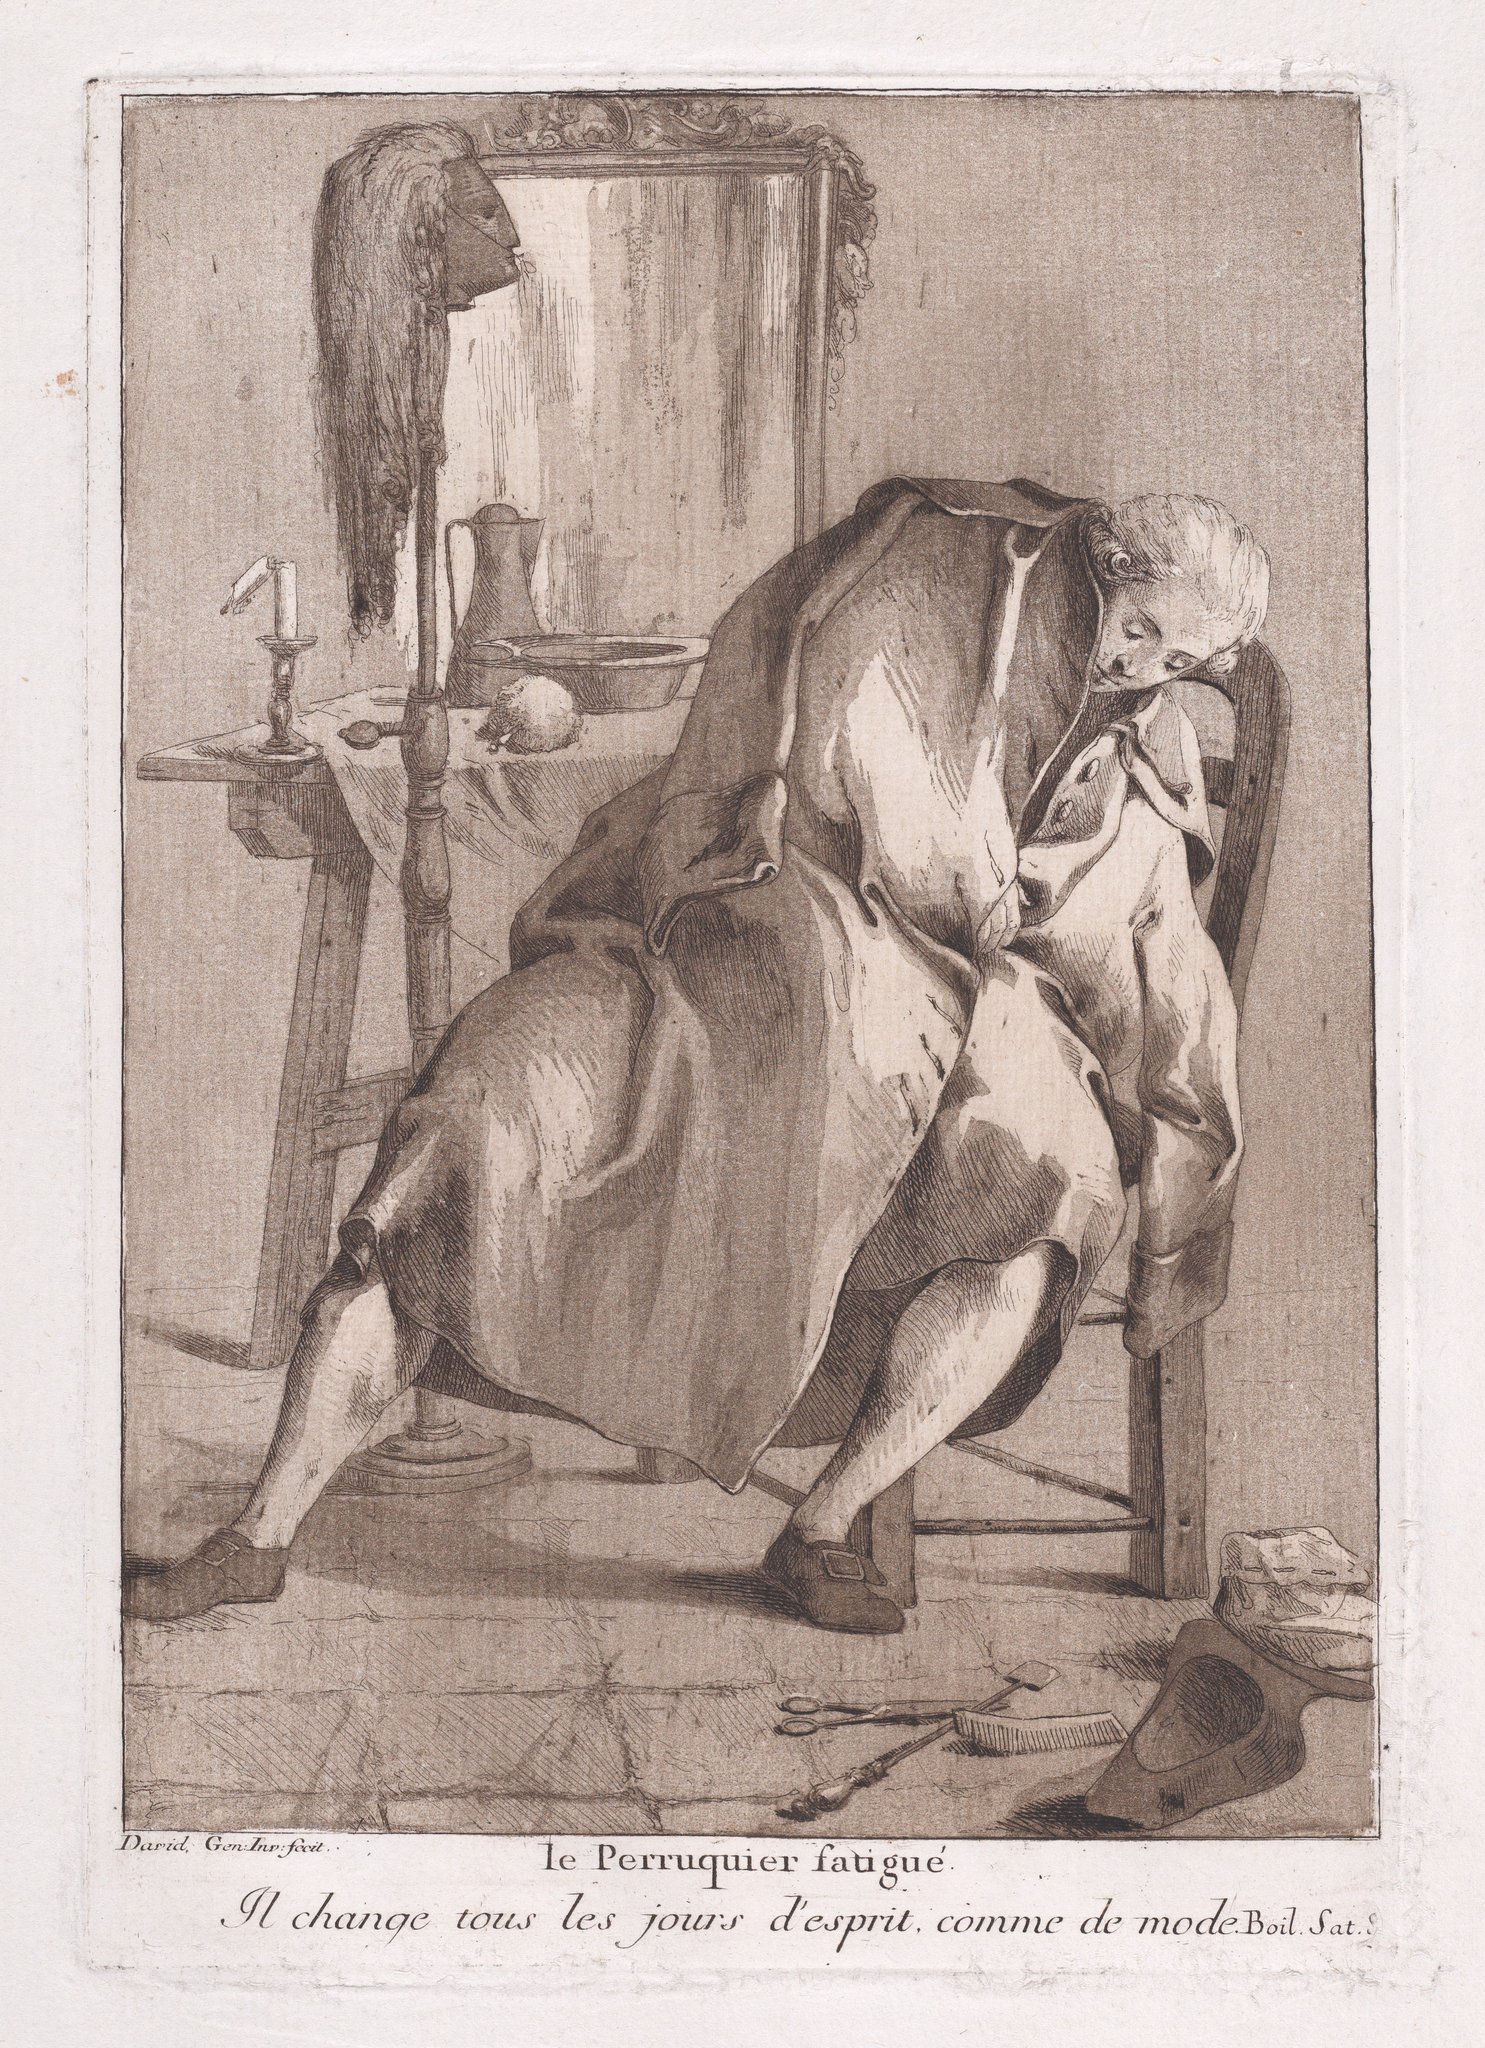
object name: print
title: The Tired Wigmaker, from "Divers Portraits"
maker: giovanni david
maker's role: artist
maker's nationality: italian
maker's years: 1749-1790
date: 1775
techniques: aquatint, etching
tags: sleeping